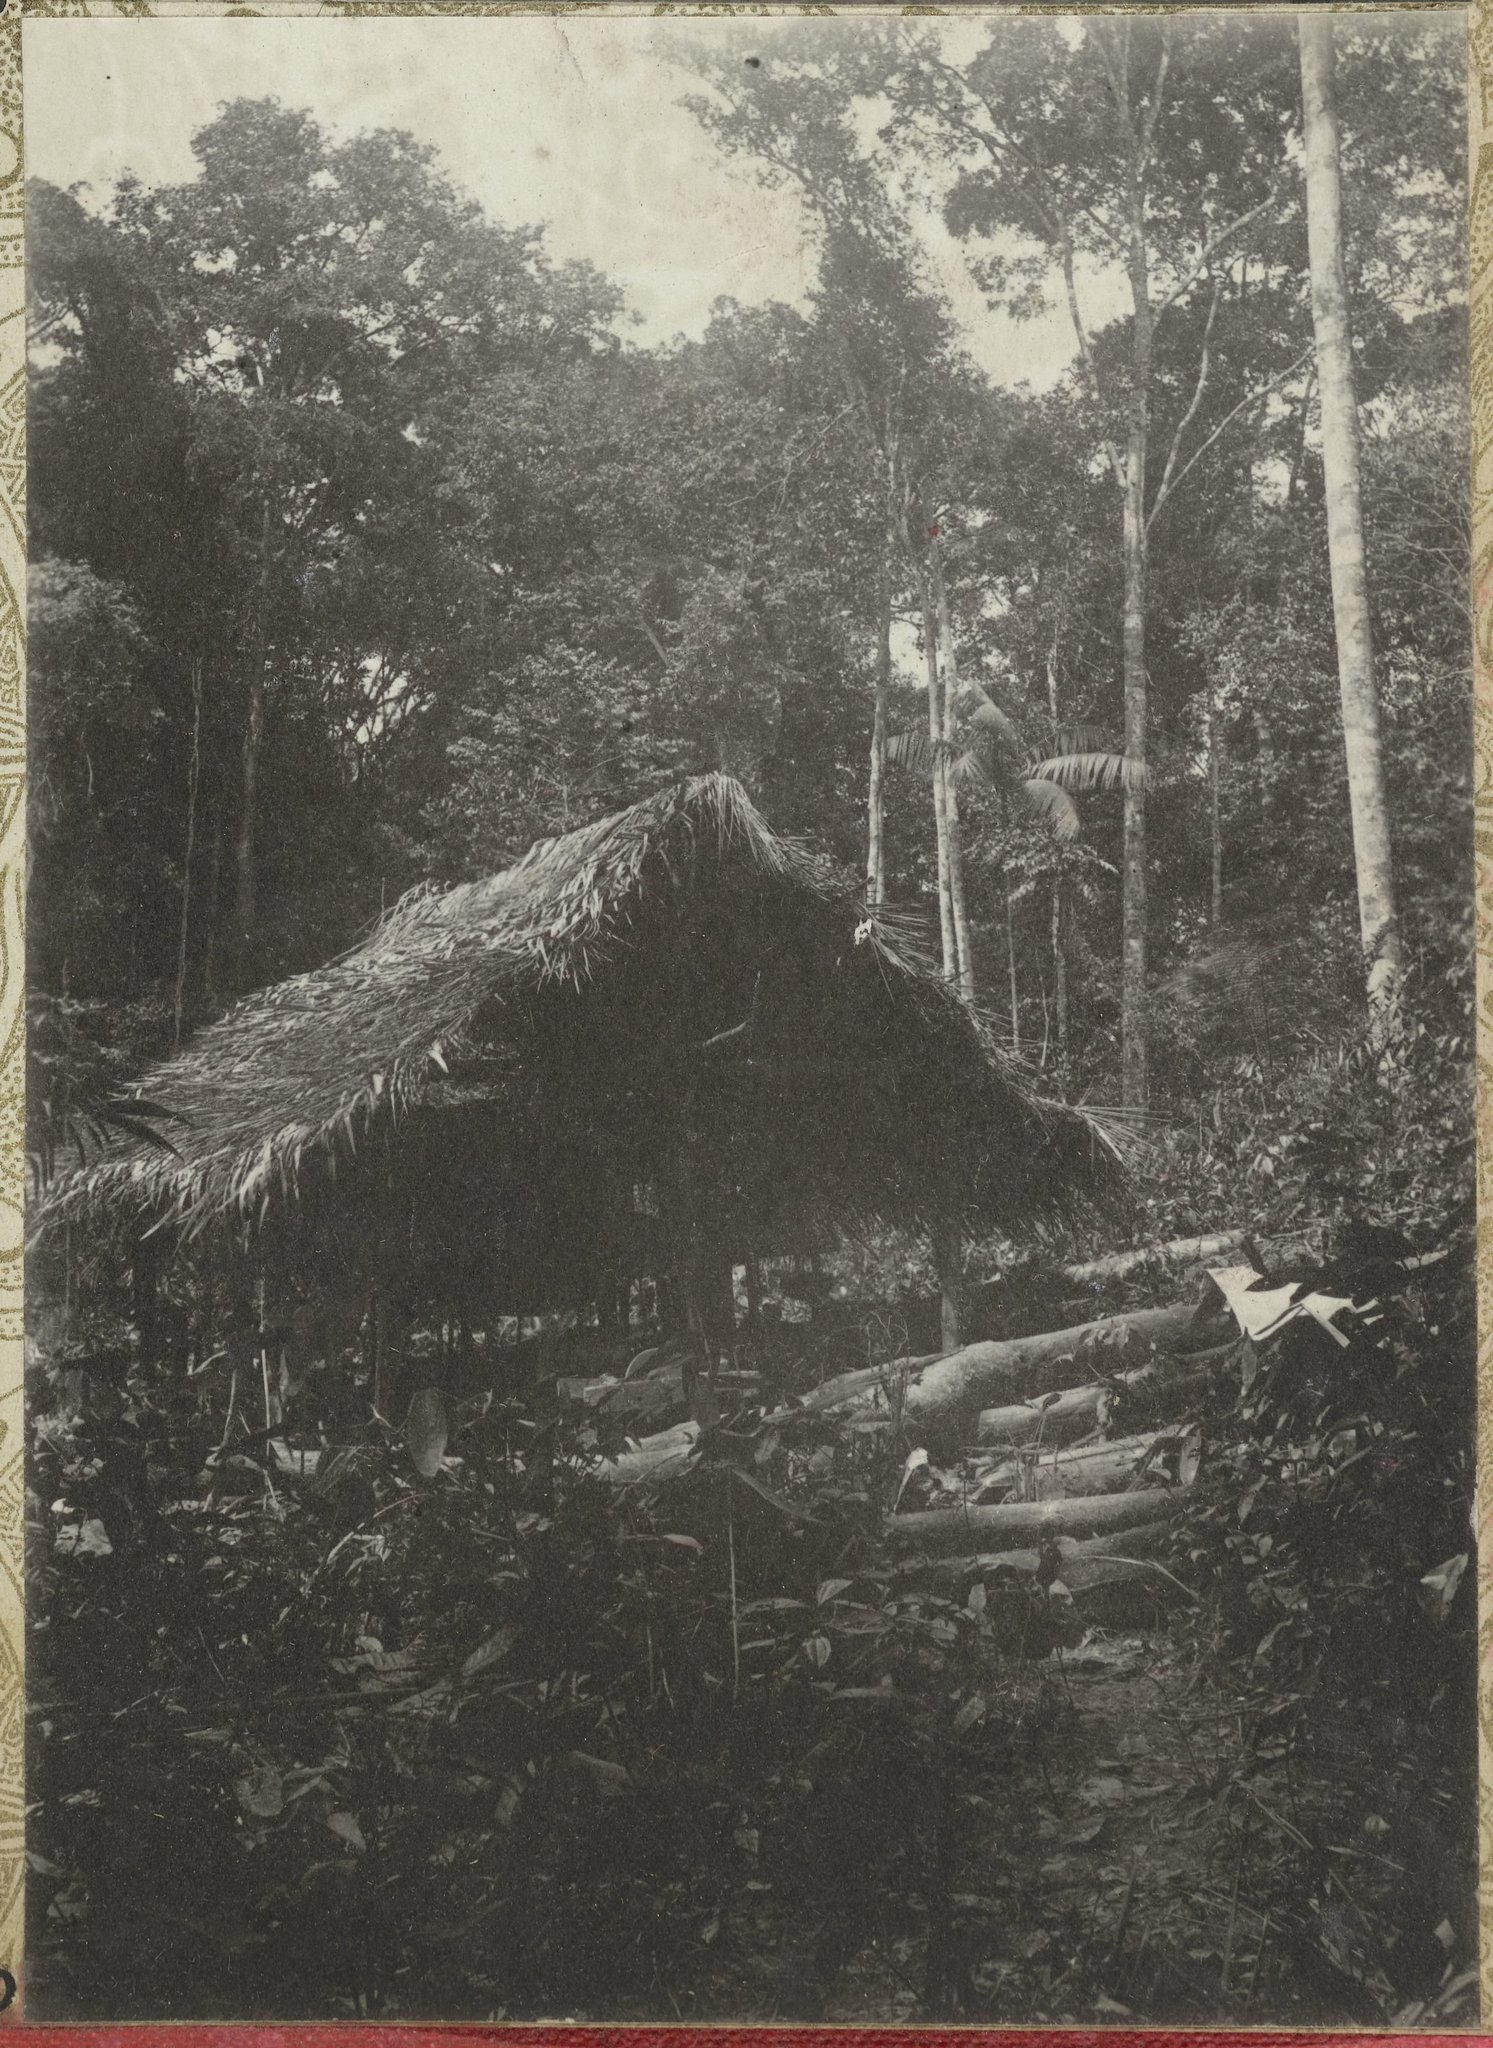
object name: photograph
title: Gouddelverskamp aan den voet van den Brownsberg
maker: hendrik doijer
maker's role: engineer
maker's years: 1863-1925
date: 1903-1910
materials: photographic support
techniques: gelatin silver print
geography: suriname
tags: suriname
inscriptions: inscription: ‘30’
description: Hut in het kamp van goudzoekers bij de Browns Berg. Onderdeel van het fotoalbum Souvenir de Voyage (deel 1), over het leven van de familie Doijer in en rond de plantage Ma Retraite in Suriname in de jaren 1903-1910.